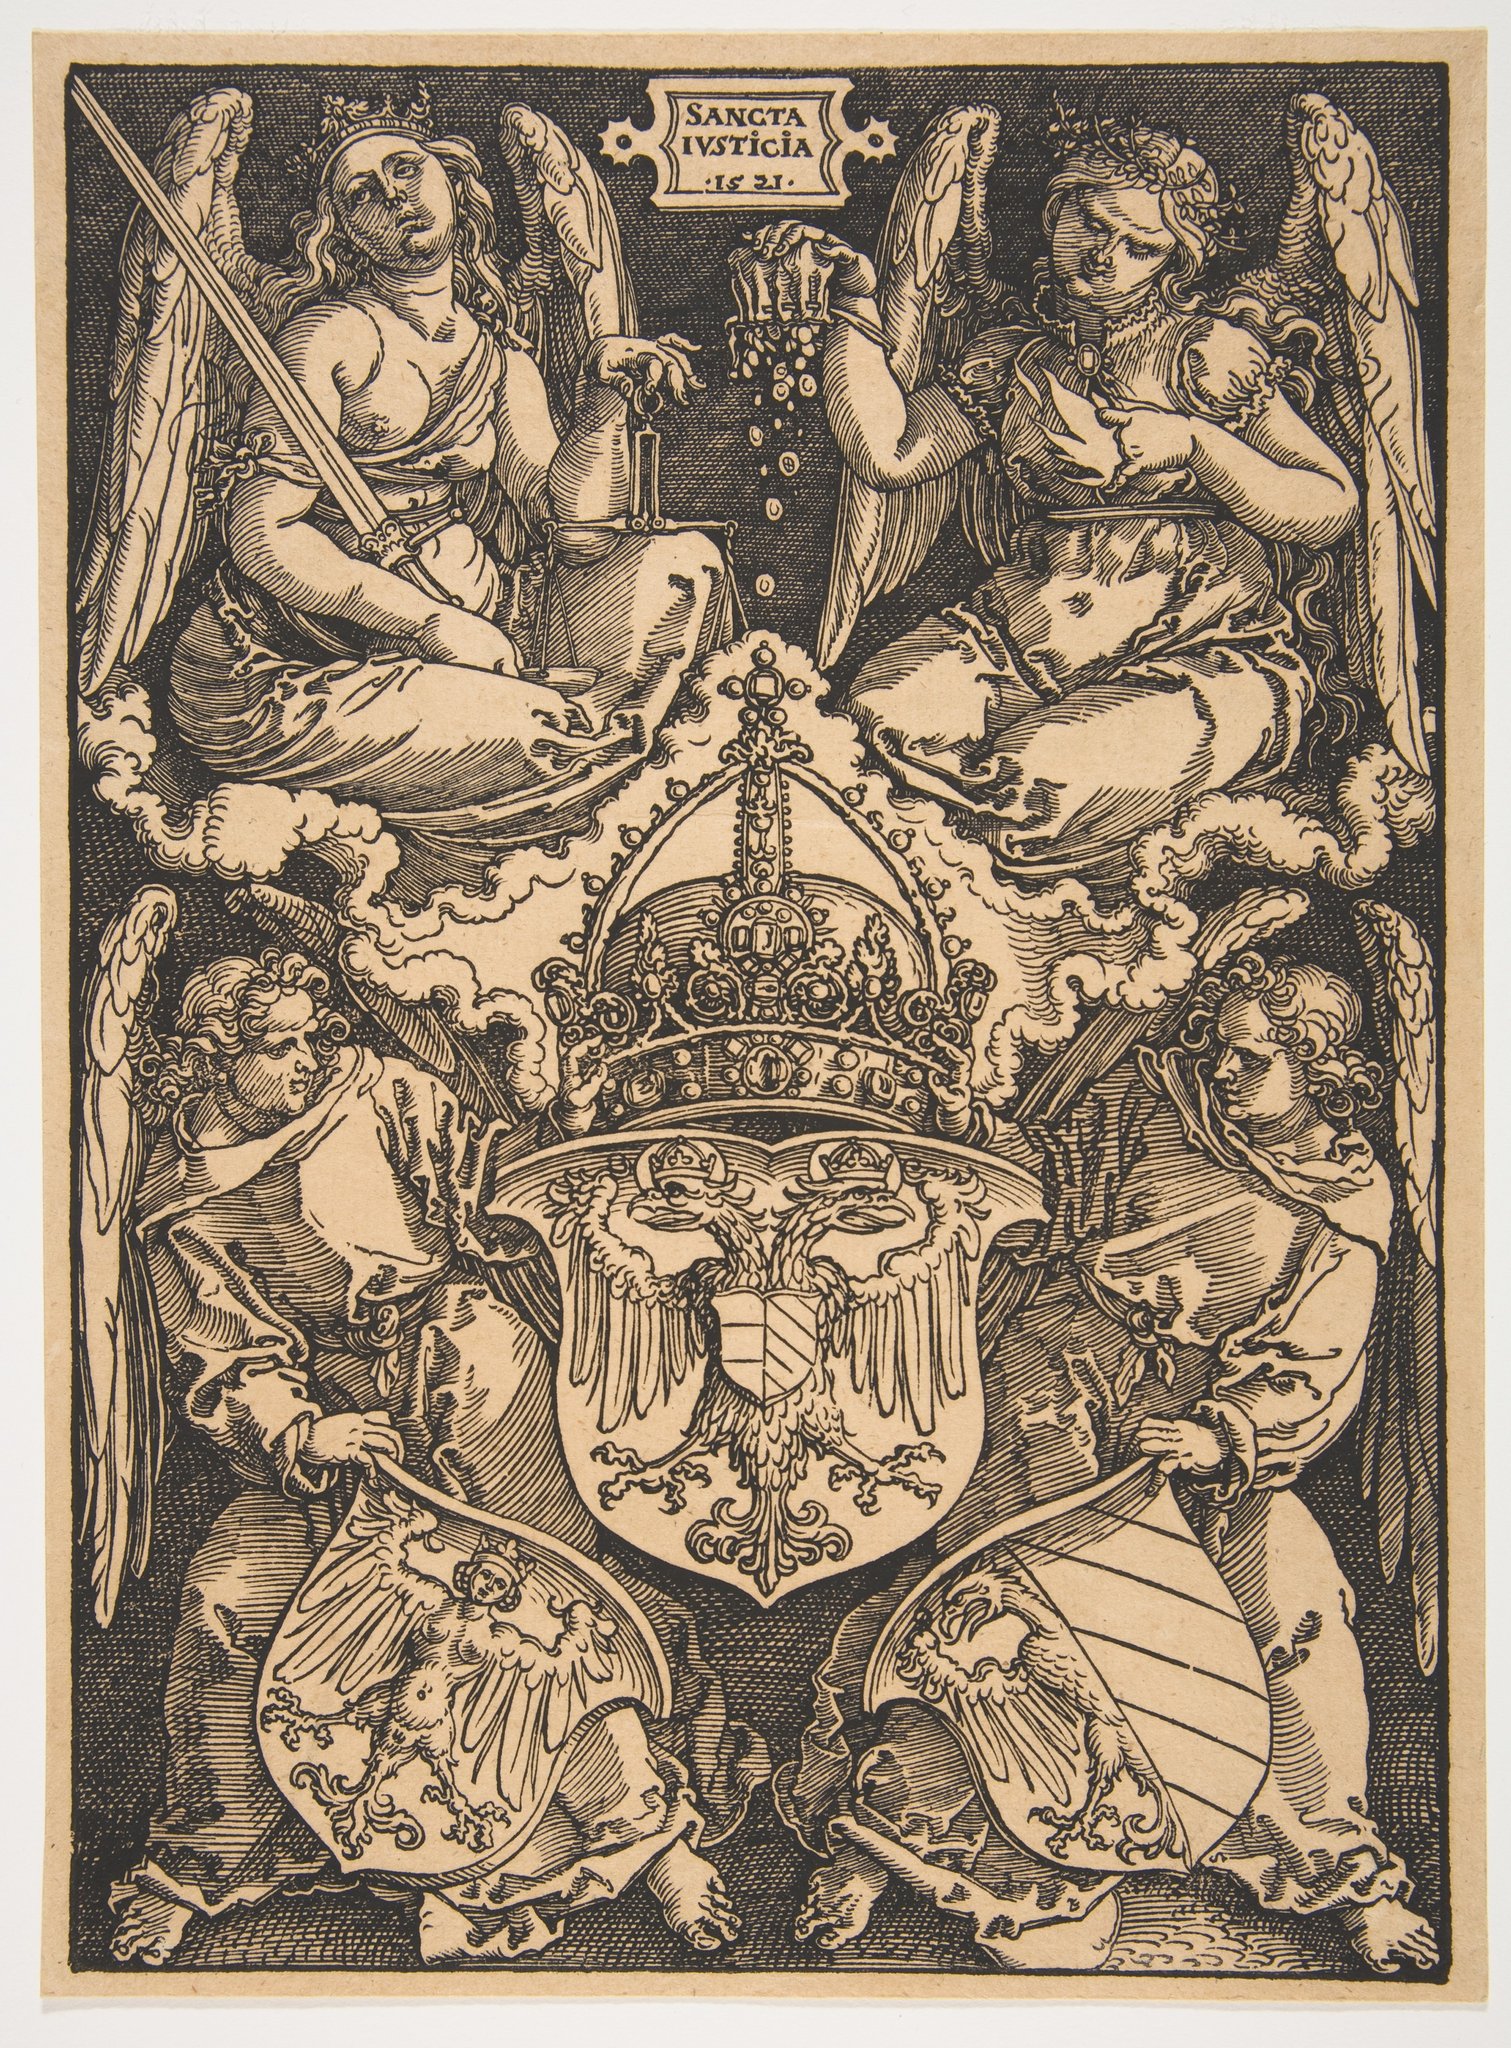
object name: print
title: The Arms of the Holy Roman Empire and of the City of Nuremberg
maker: albrecht dürer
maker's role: artist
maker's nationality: german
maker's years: 1471-1528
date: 1521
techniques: woodcut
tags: swords,coat of arms